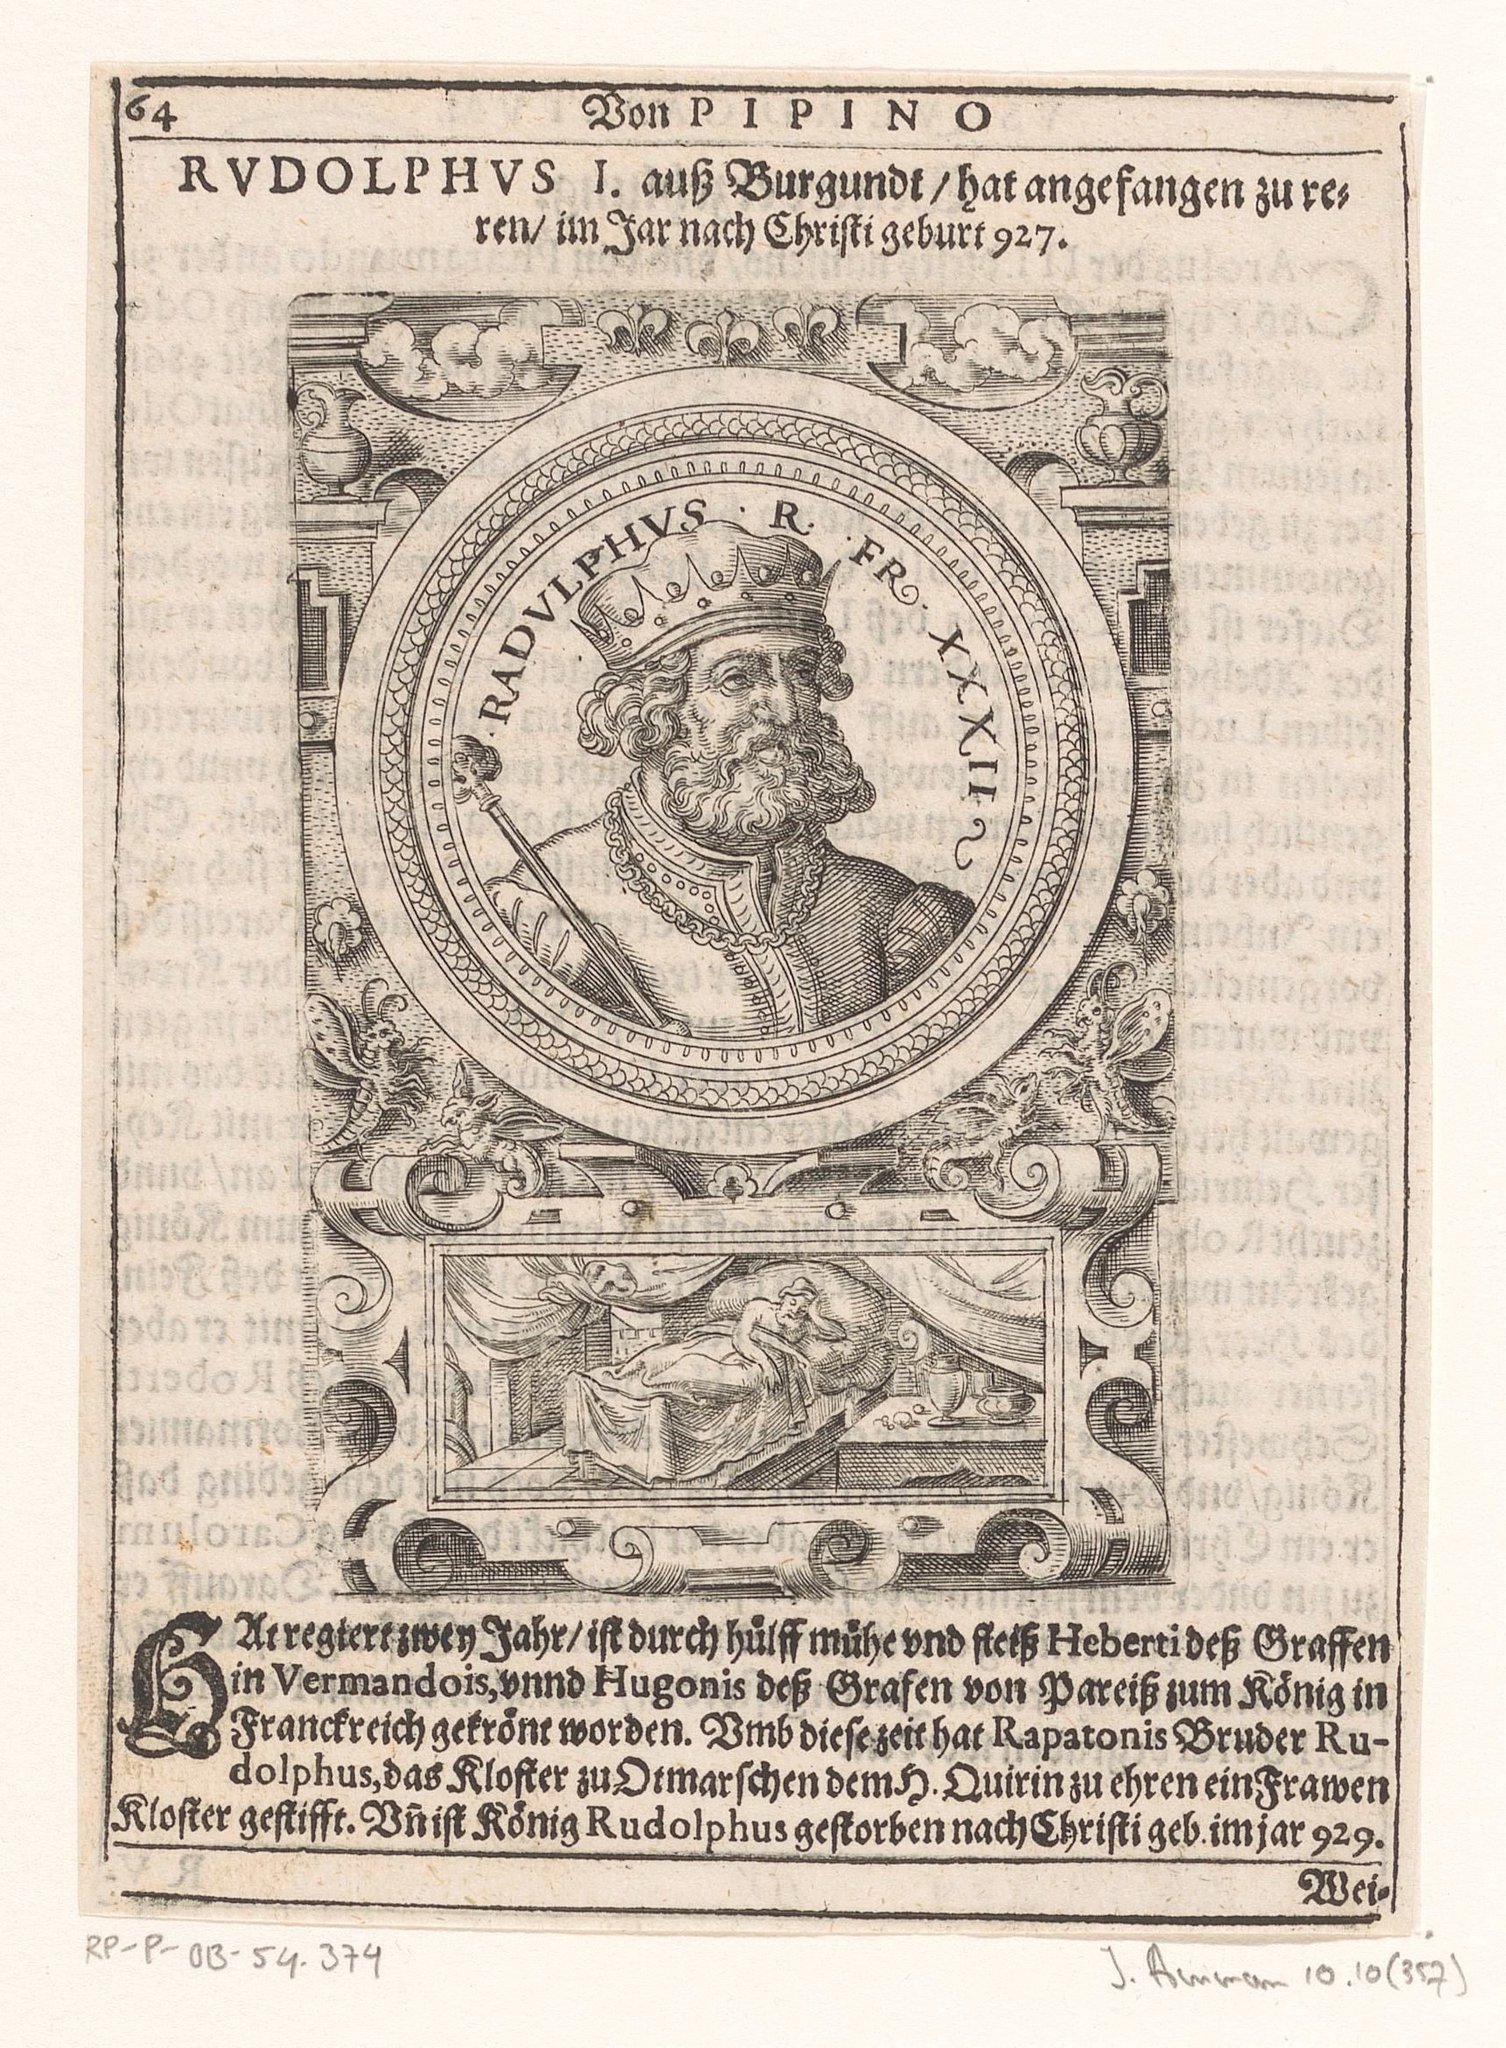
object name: book illustration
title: Portret van Rudolf van Frankrijk, koning van West-Francië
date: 1598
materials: paper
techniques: engraving, etching, intaglio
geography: nuremberg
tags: scrollwork, strapwork ~ ornament, historical persons, ruler, sovereign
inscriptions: collector's mark: Lugt 2228, number: ‘158’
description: Prent afkomstig uit de publicatie: Michael Eizinger. Könige in Frankreich. Keulen: Johann Bussemacher, 1598, p. 64. De publicatie bevat prenten van Jost Amman en Virgil Solis.